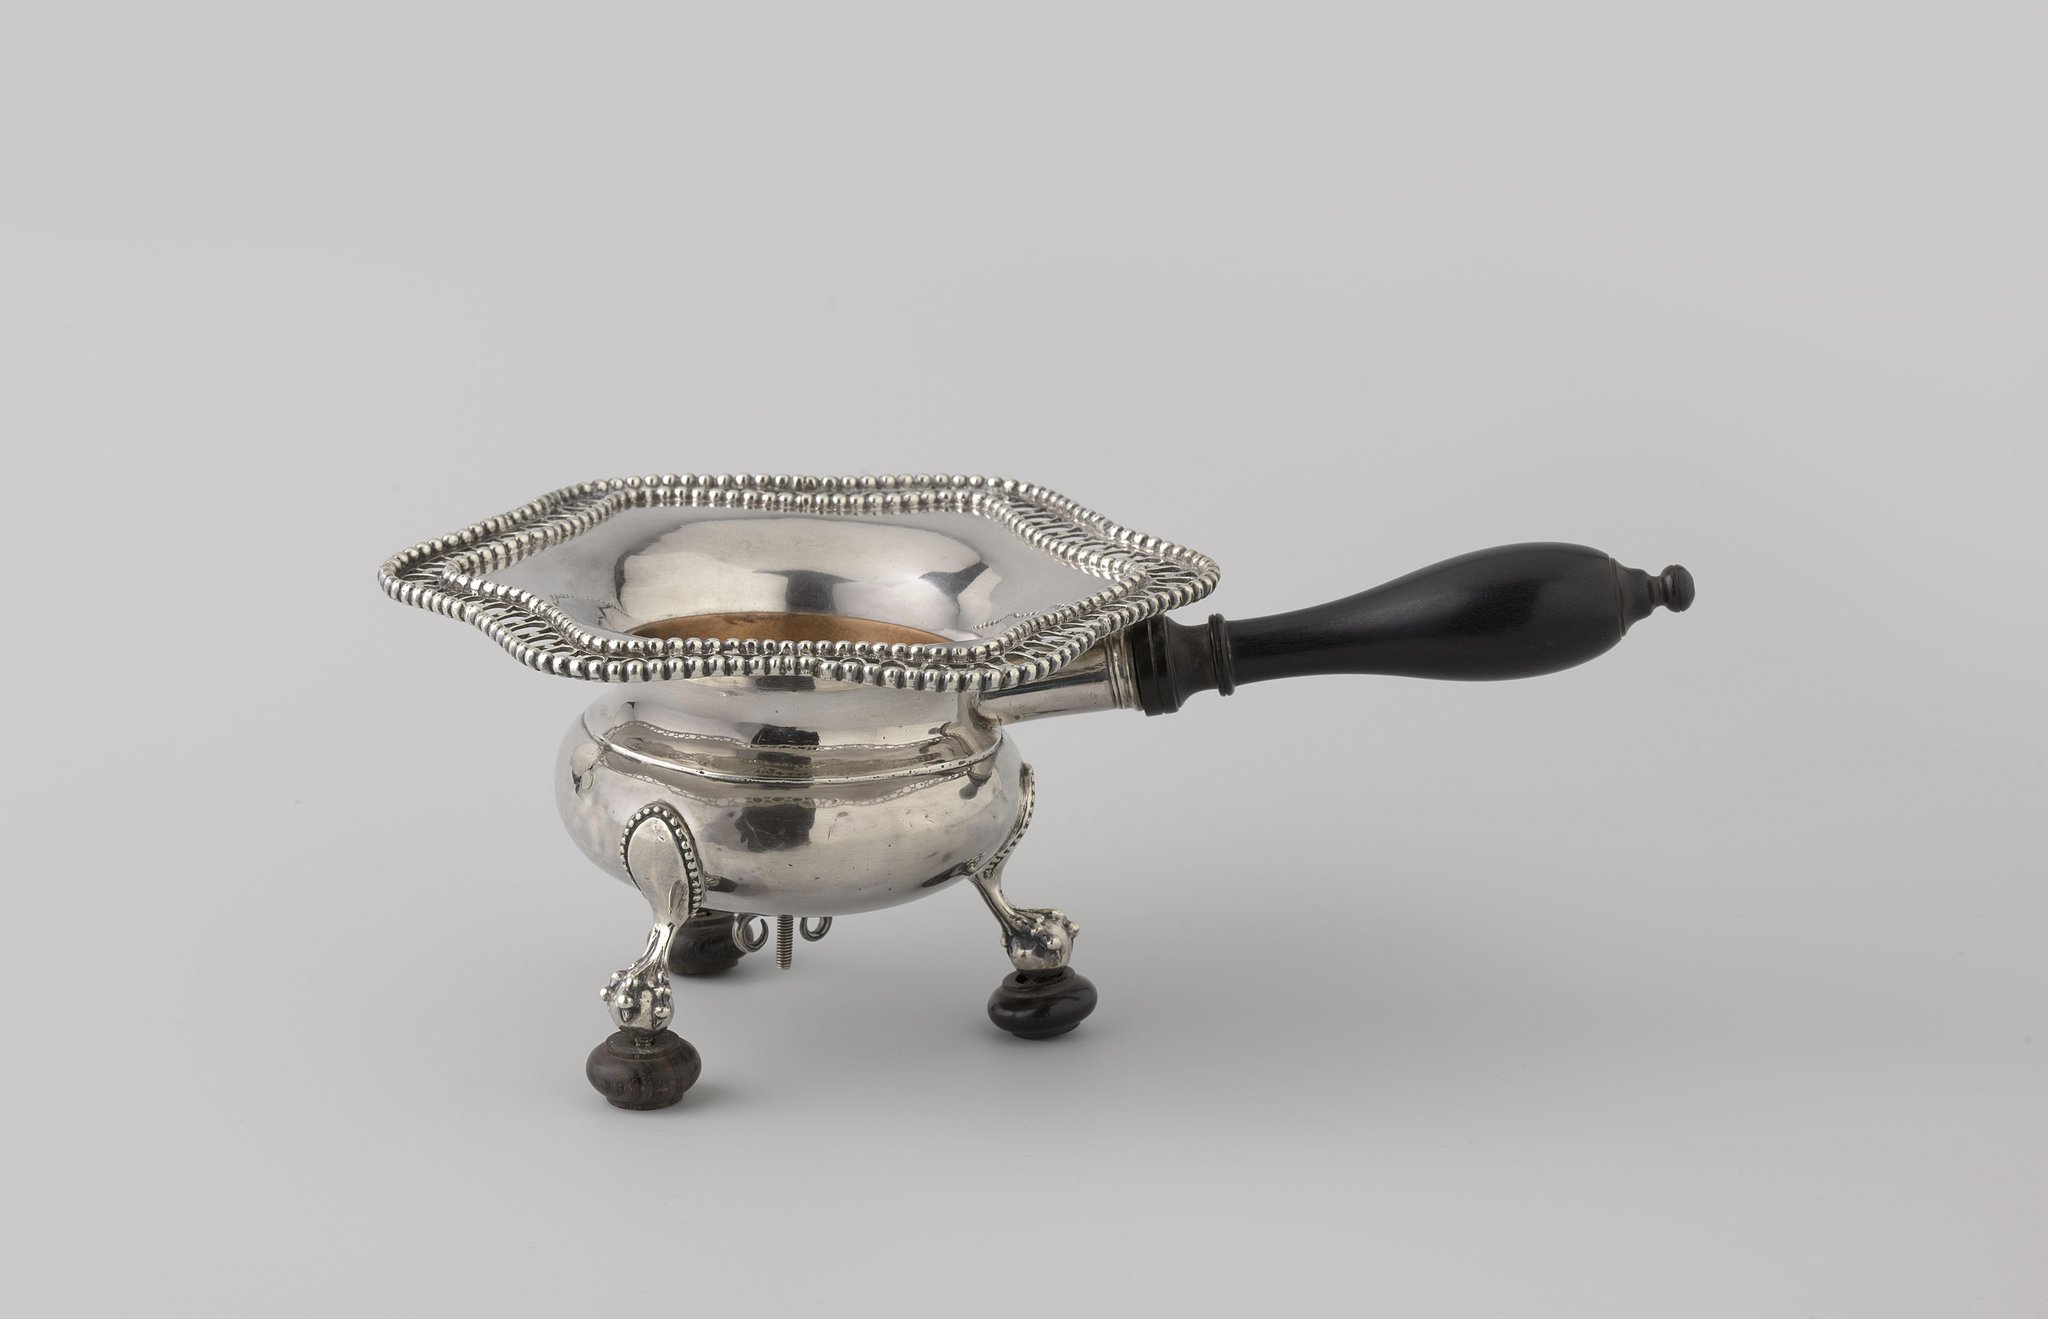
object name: komfoor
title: Pijpenkomfoor met steel en gewelfde wand met zes ingezwenkte hoeken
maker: wouterus verschuur (zilversmid)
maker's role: silversmith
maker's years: 1756-1828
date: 1787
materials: copper, wood, silver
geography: amsterdam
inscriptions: maker's mark, alloy mark, duty mark, date letter: ‘C’, town mark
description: De ronde pijpenkomforen hebben drie gegoten poten, gevormd als vogelkauwen die een bal omvatten, rustend op ebbenhouten klossen, en een geprofileerde ebbenhouten steel. De poten hebben een ovale aanzet die is omrand door een parellijst. De bak bestaat uit een gedrukt bolvormige bodem en een sterk gewelfde wand met een rand met zes ingezwenkte hoeken. Het buitenste, liggende gedeelte van de rand is opengewerkt met door kleine bolletjes verbonden ovalen, tussen twee parellijsten. Hier vlak onder bevindt zich het zilveren verbindingsstuk van de steel dat bij de aanhechting van het hout omgeven is door een profielrand. De roodkoperen binnenbak is aan het komfoor bevestigd met een zilveren schroef, aan de bovenzijde eindigend in een rozetvormig knopje, en aan de onderzijde vastgedraaid met een moer met opkrullende uiteinden.